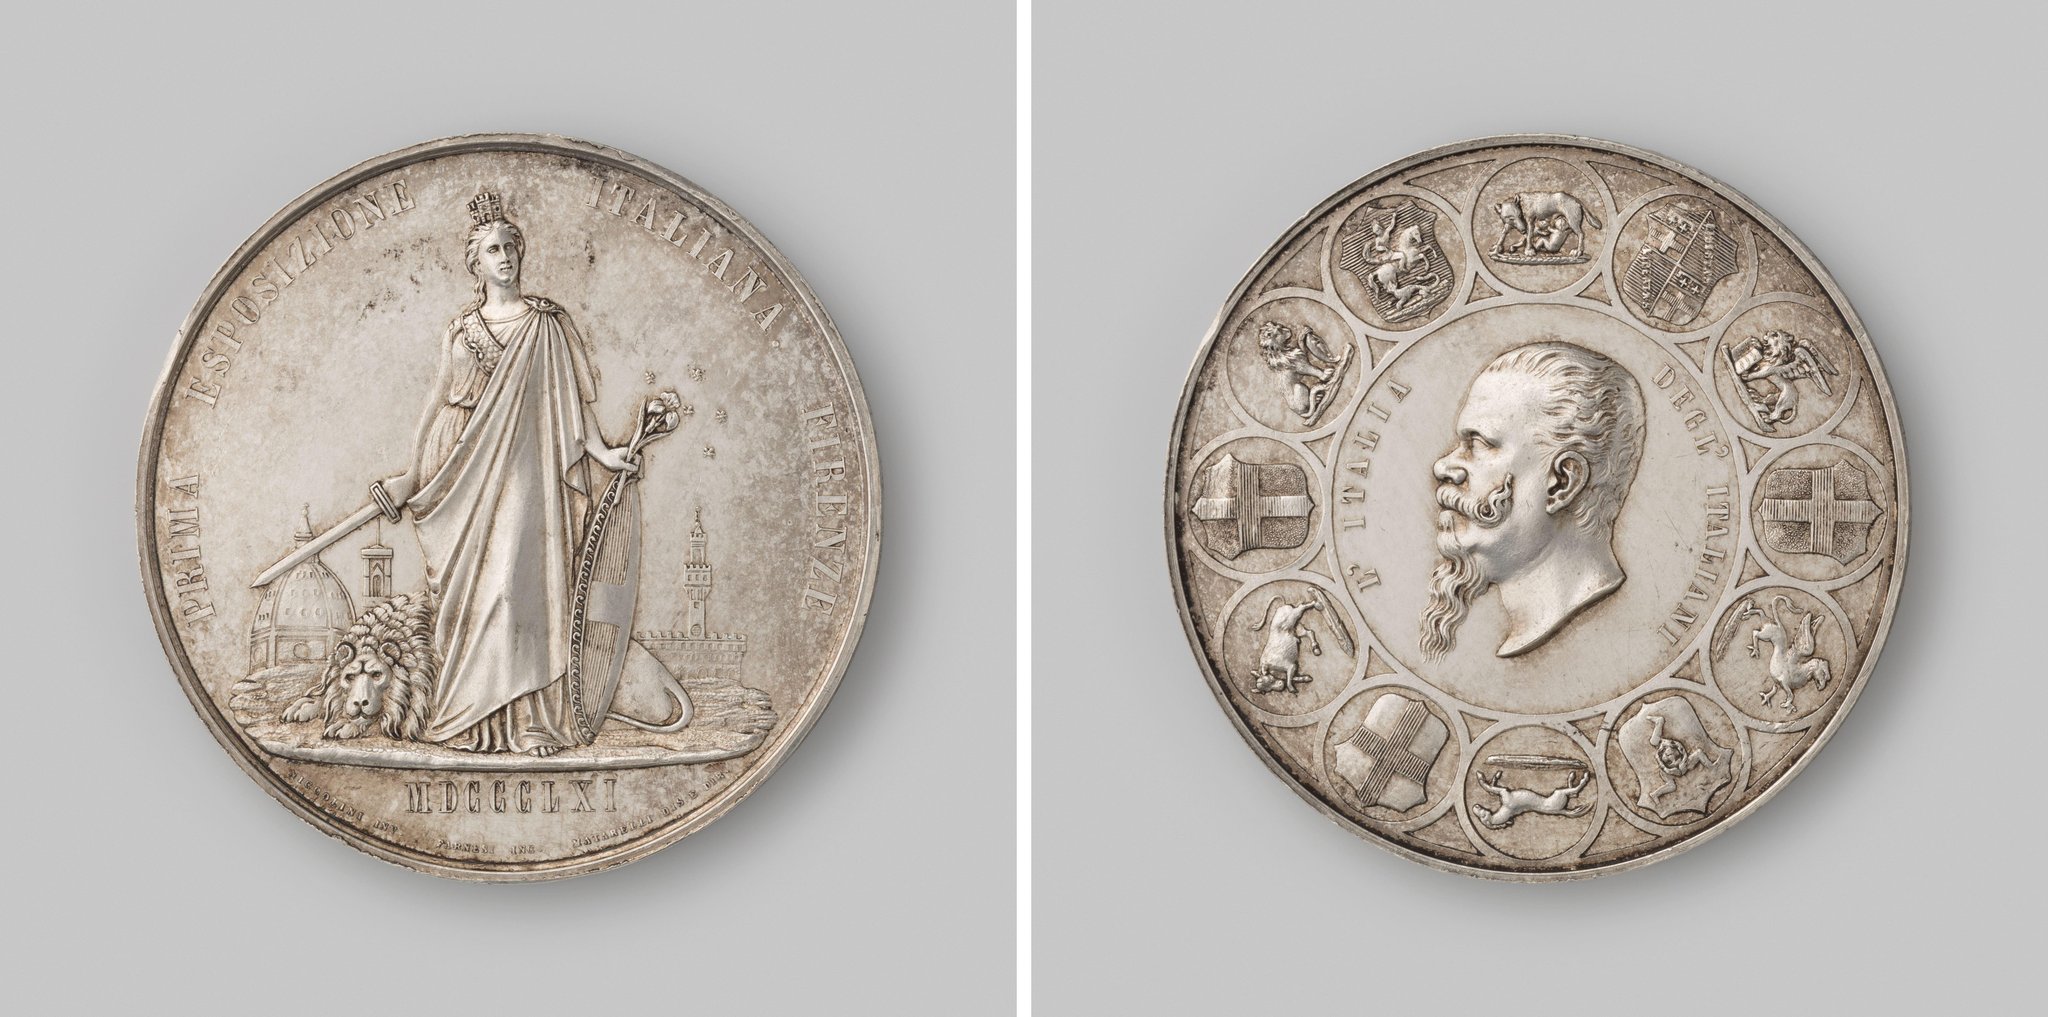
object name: history medal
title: Eerste Italiaanse Tentoonstelling te Florence 1859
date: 1859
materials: silver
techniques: striking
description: Zilveren penning, op de voorzijde de stadsgodin van Florence met zwaard, schild en lelie, een leeuw aan haar voeten en op de achtergronf de stad Florence, met omschrift en afsnedetekst, op de keerzijde het portret van Koning Victor Emanuel met omschrift binnnen een krans van cirkels met wapenschilden en symbolen.